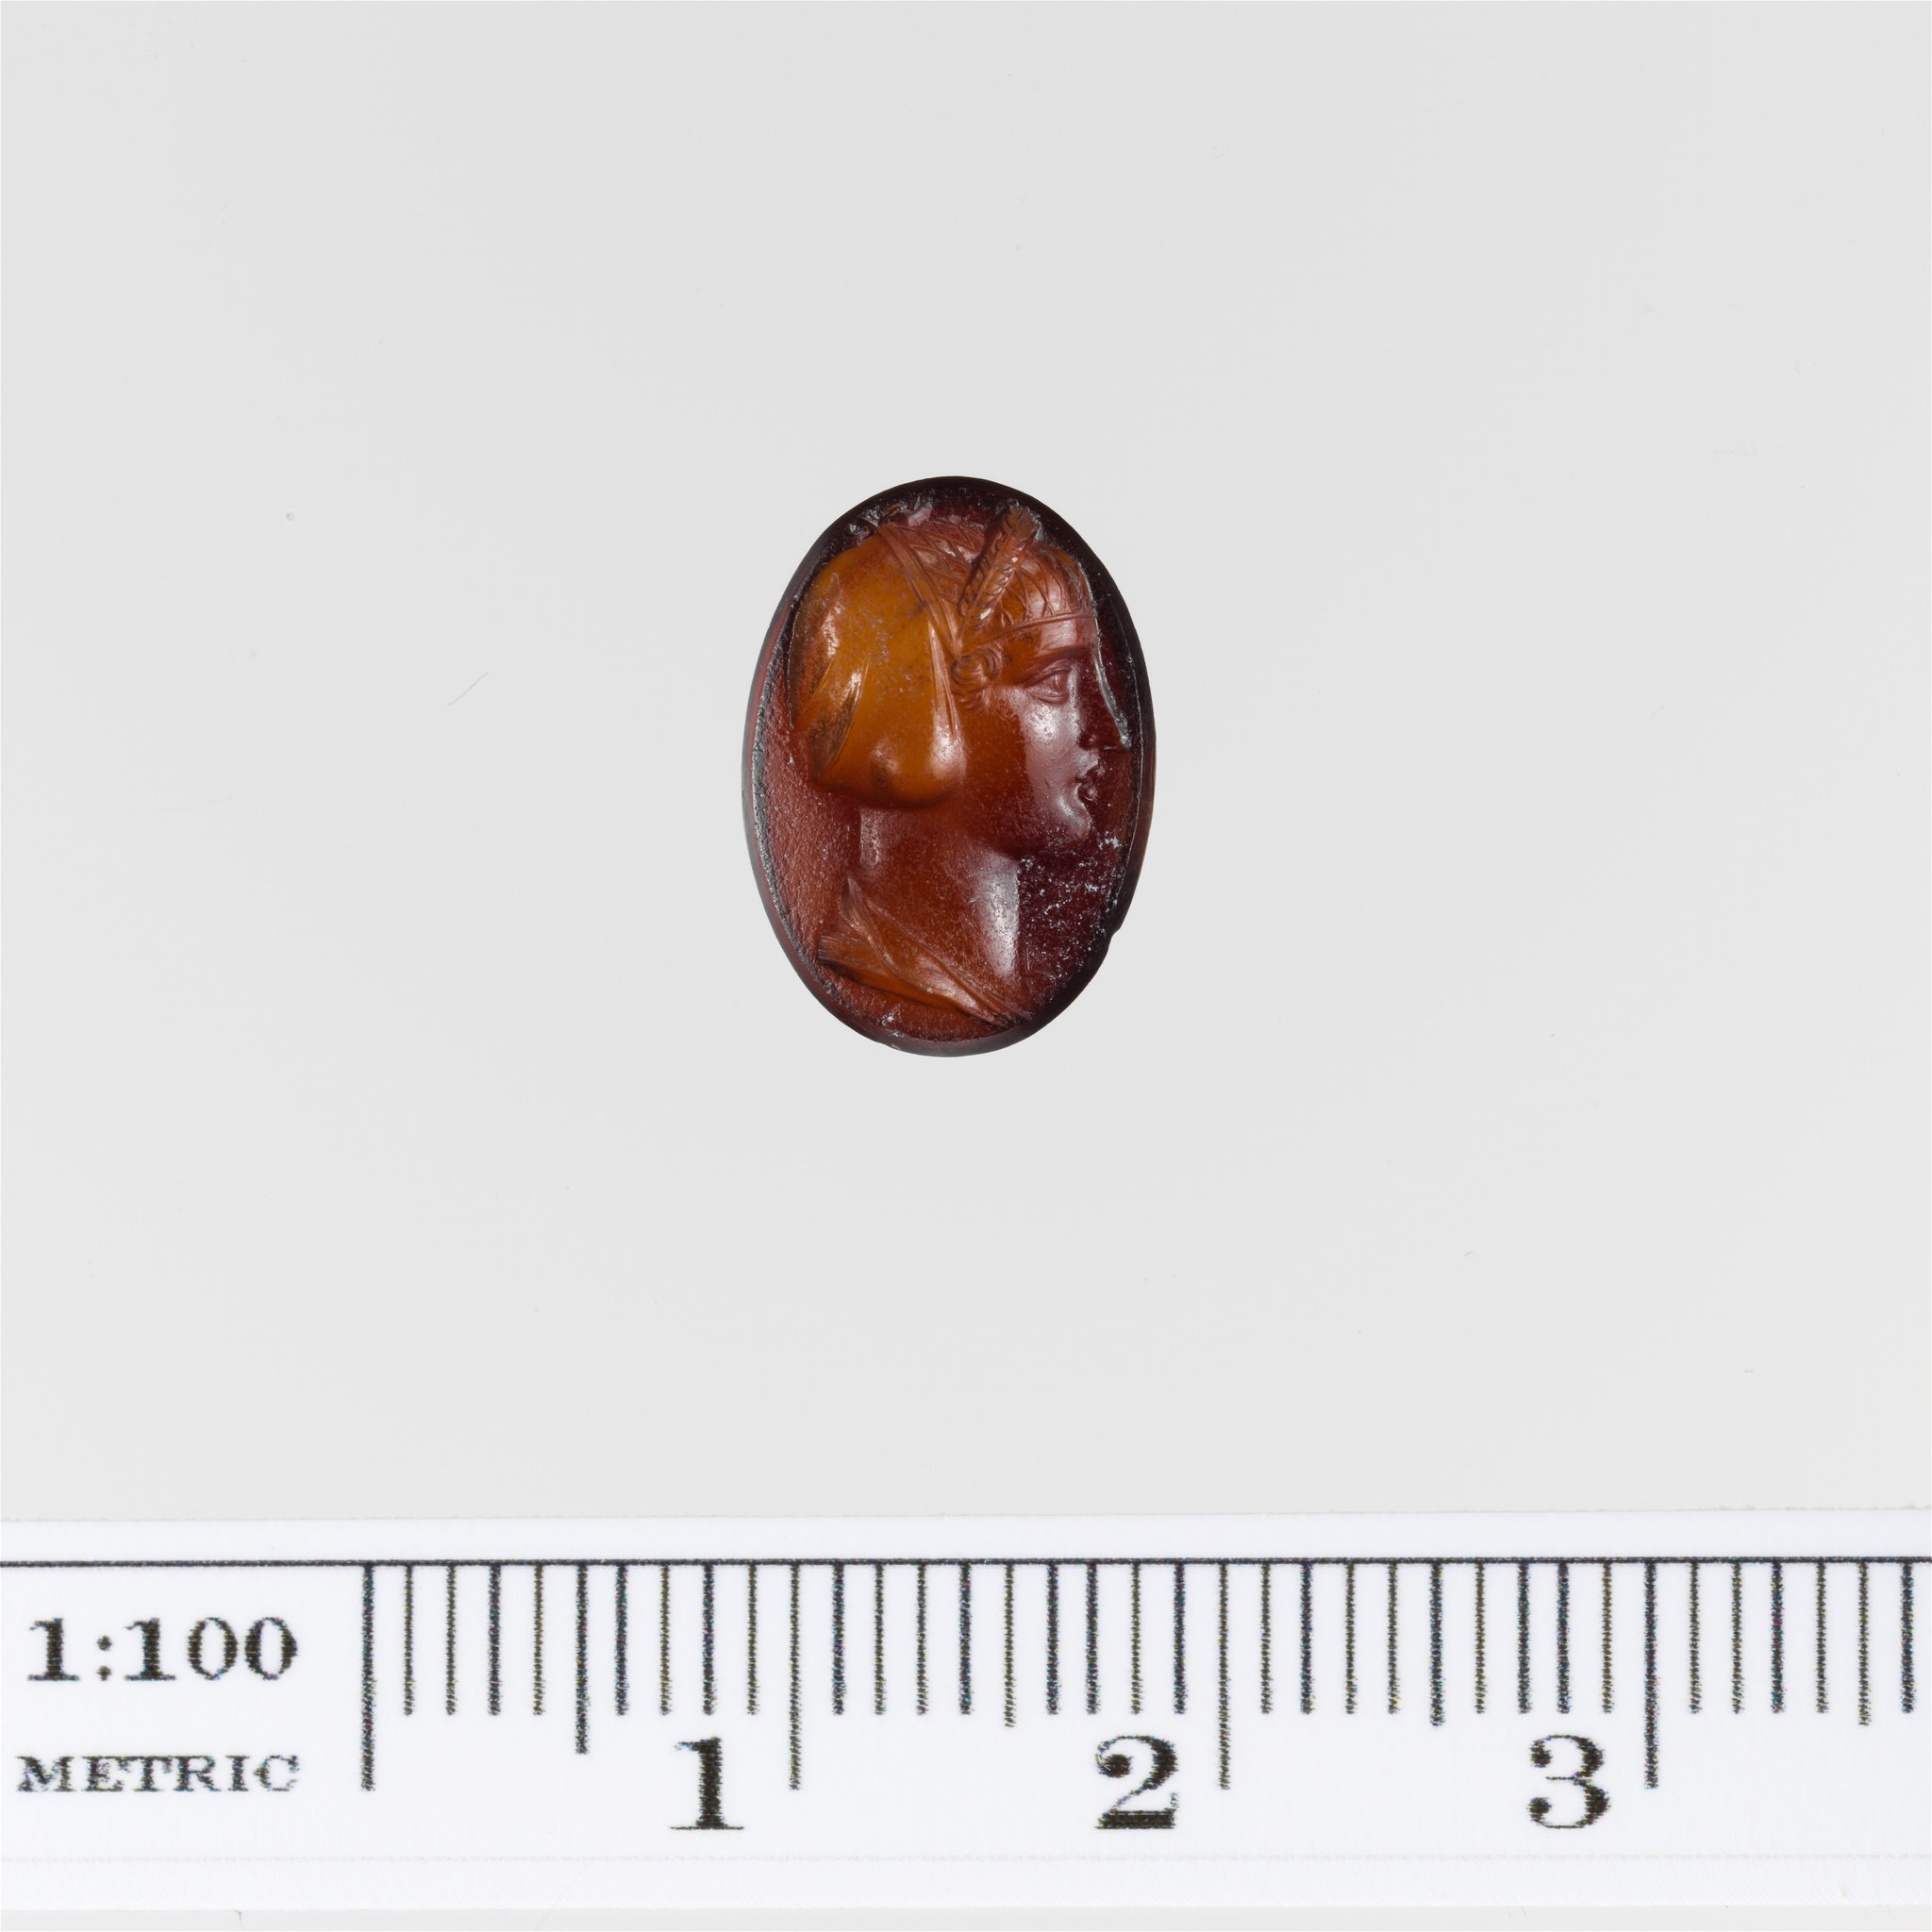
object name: intaglio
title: Carnelian ring stone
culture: roman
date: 100 BCE-300 CE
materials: gemstone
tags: profiles,women